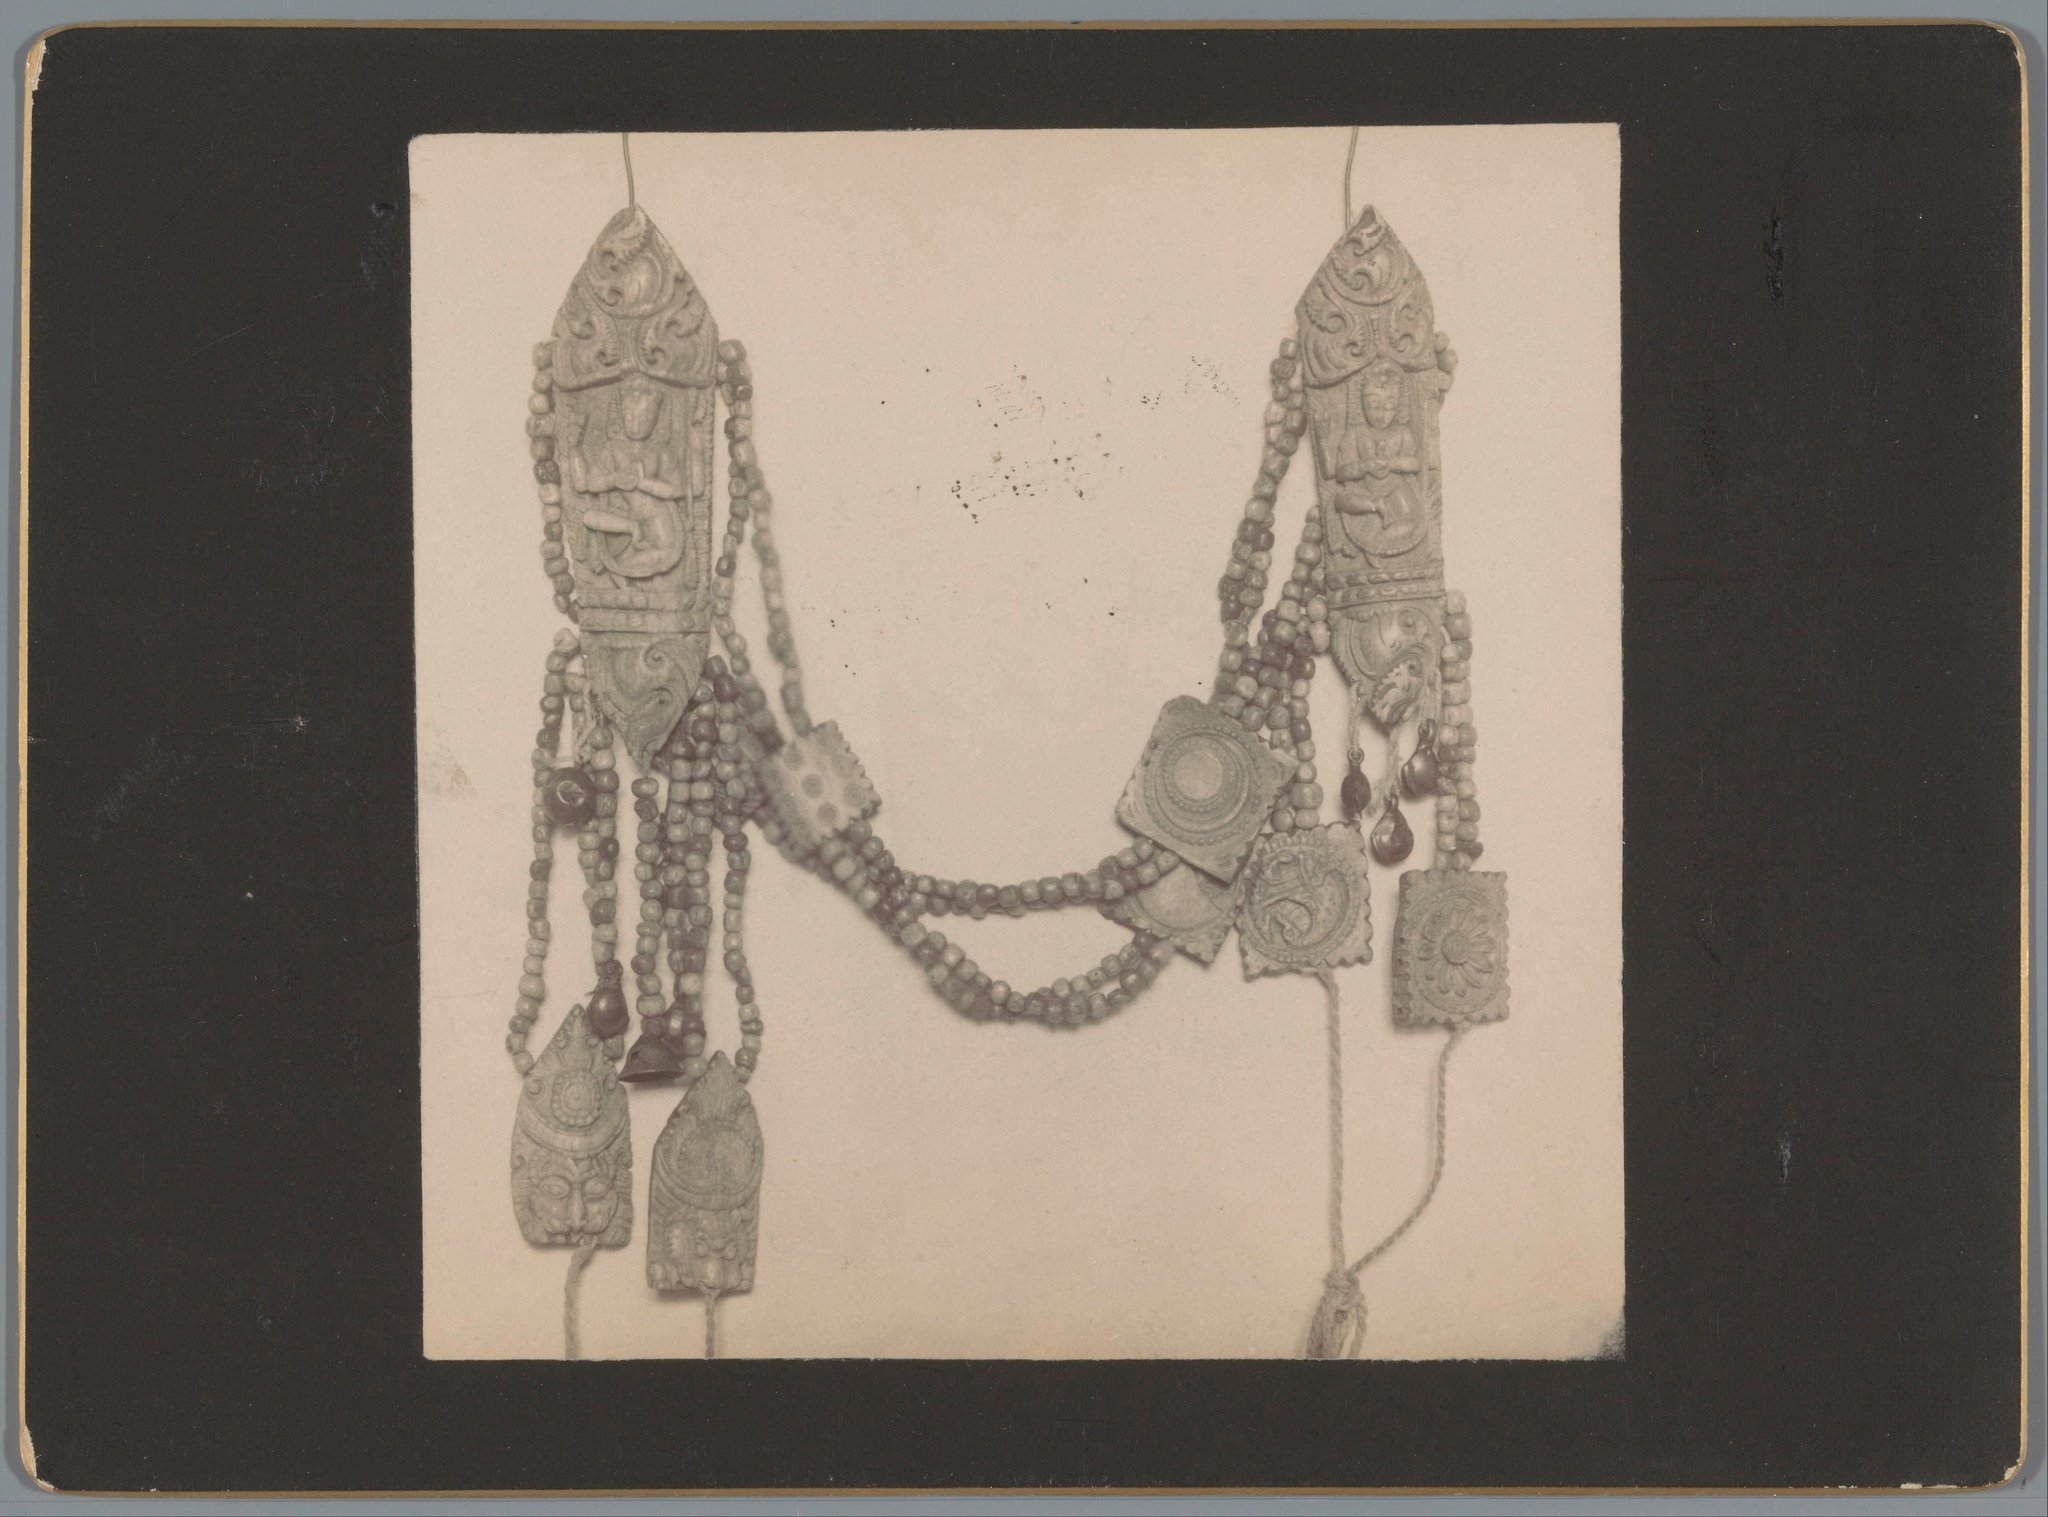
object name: photograph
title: Tibetaans halssieraad met amuletten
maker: Anonymous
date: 1890-1910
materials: cardboard, paper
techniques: albumen print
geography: rijks ethnographisch museum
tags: necklace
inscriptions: inscription: ‘Rijks Ethnographisch Museum Ser 1119/ N.70/ Halssieraad van menschenbeenderen/ gedragen als amulet door priesters gedragen/ Thibet.’